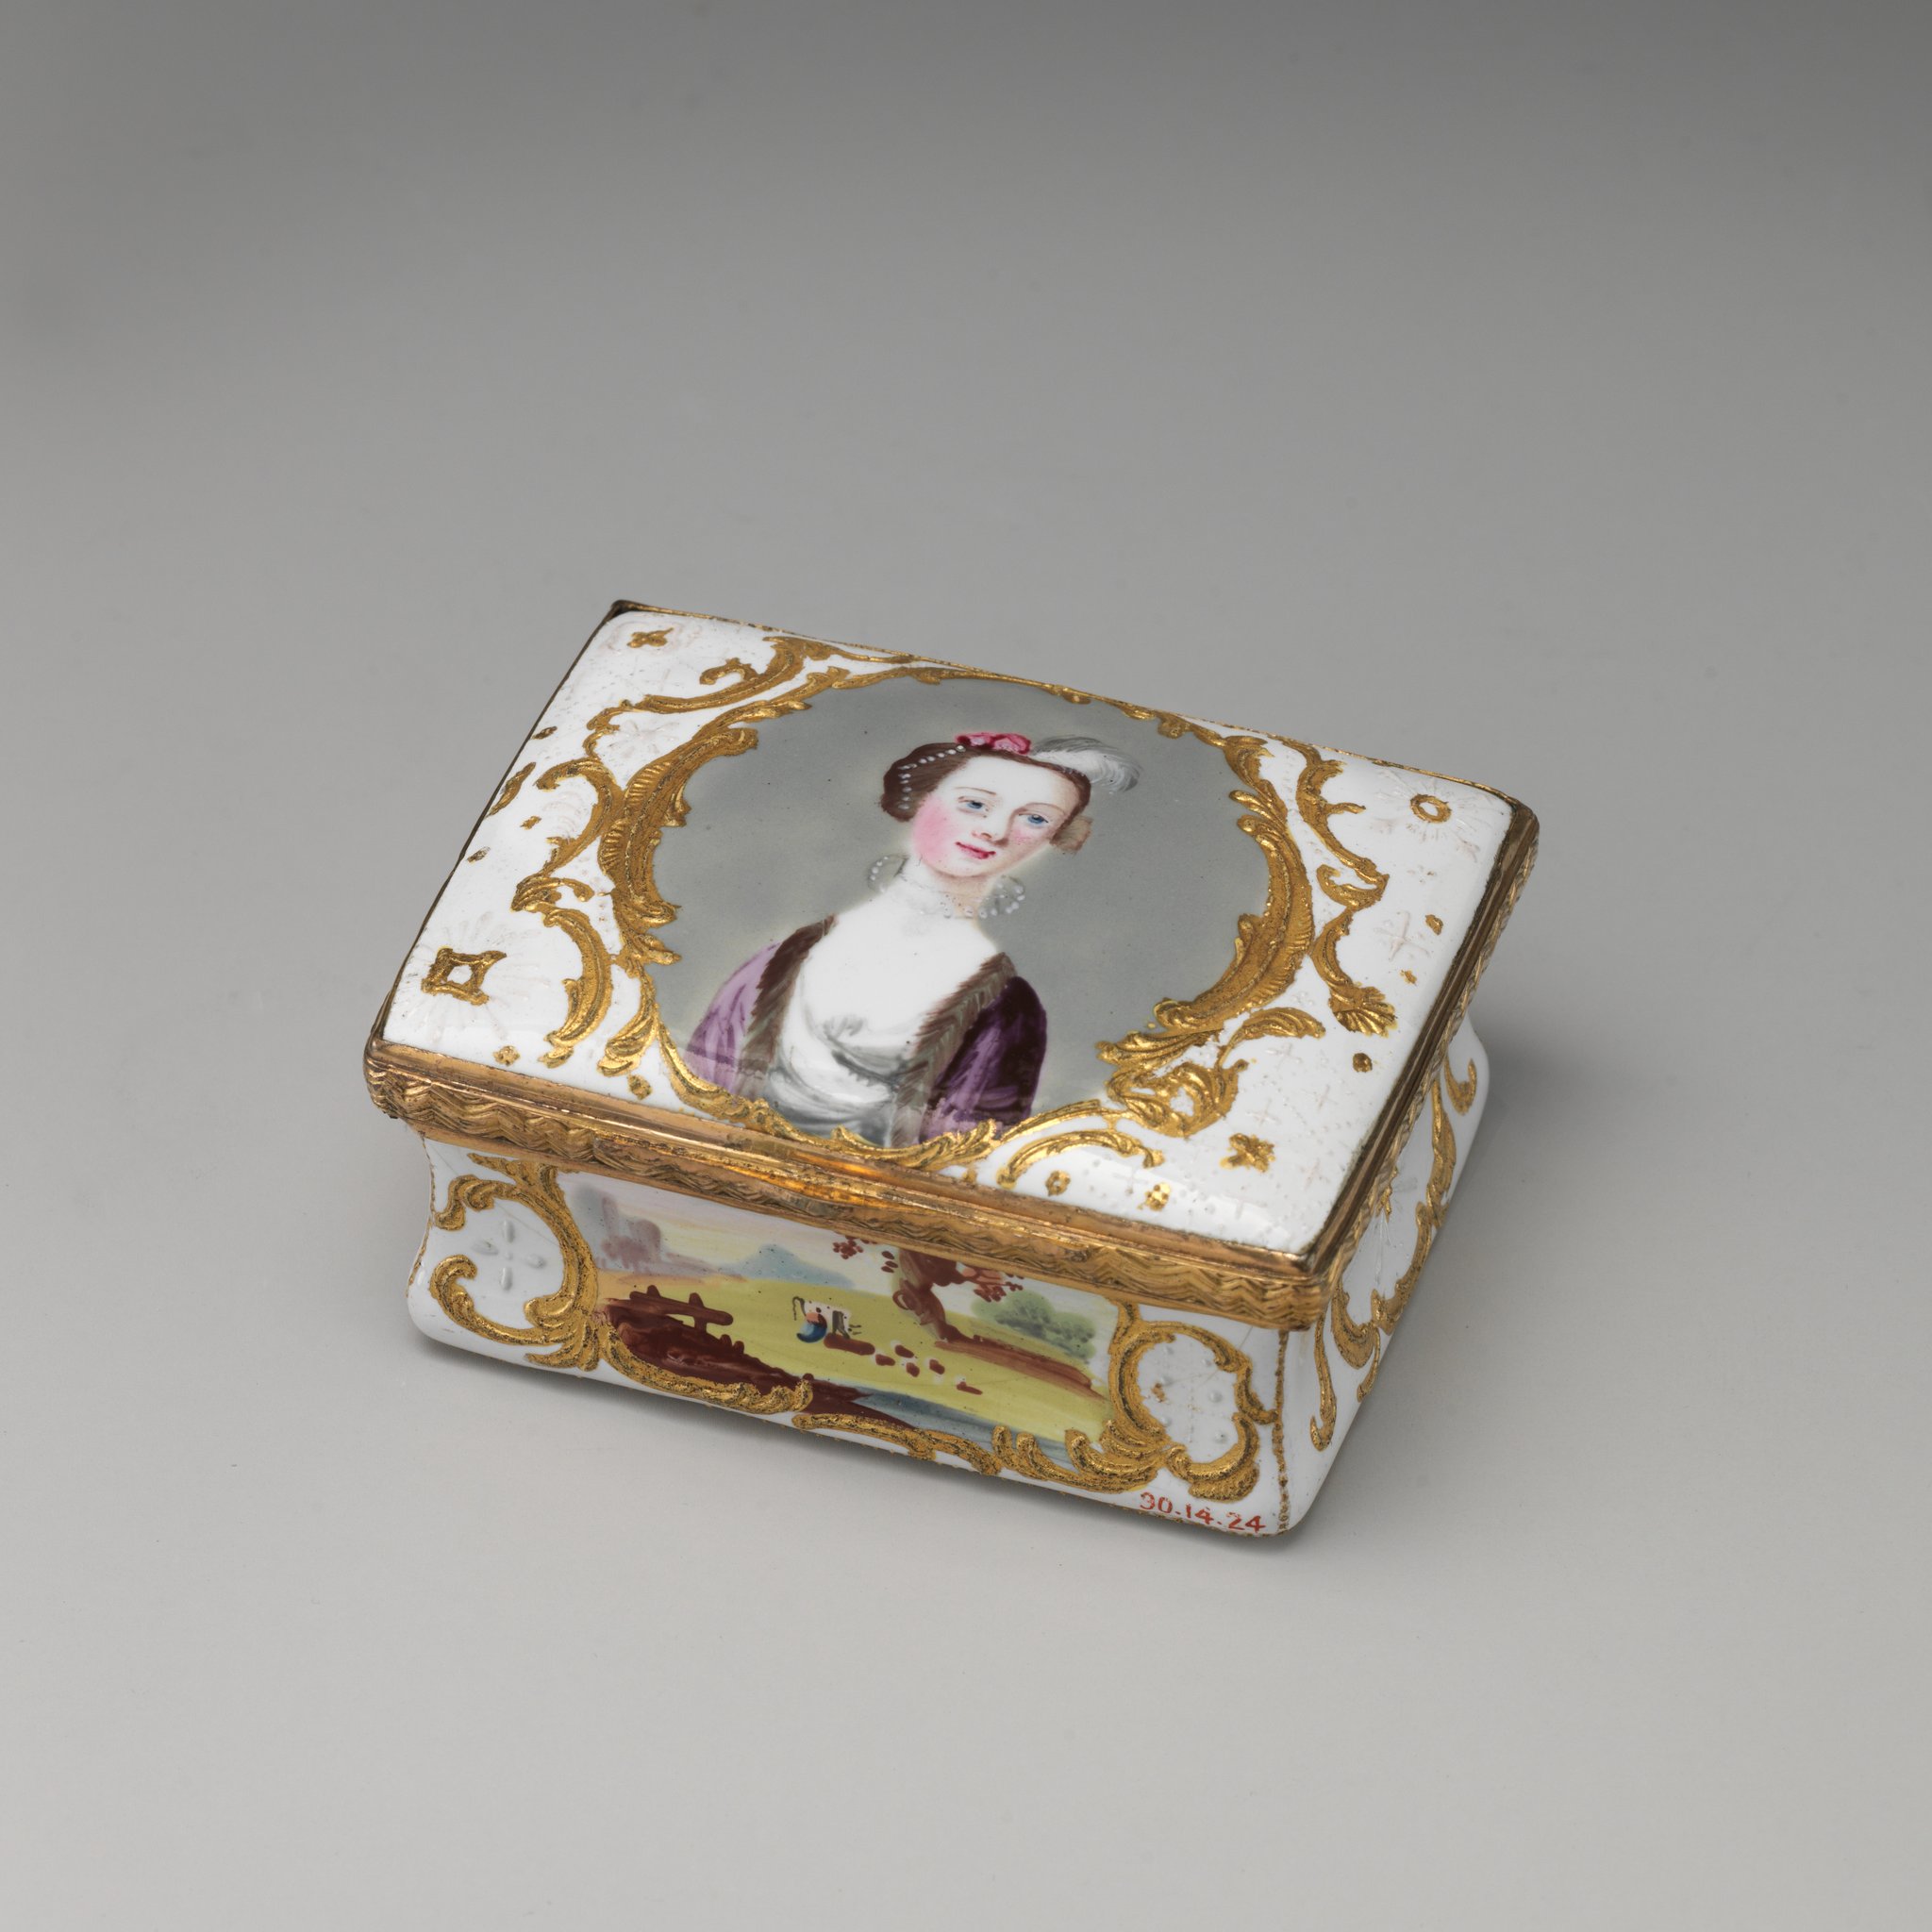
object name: snuffbox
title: Snuffbox with portrait of an unidentified woman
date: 1765-1770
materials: copper, enamel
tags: women